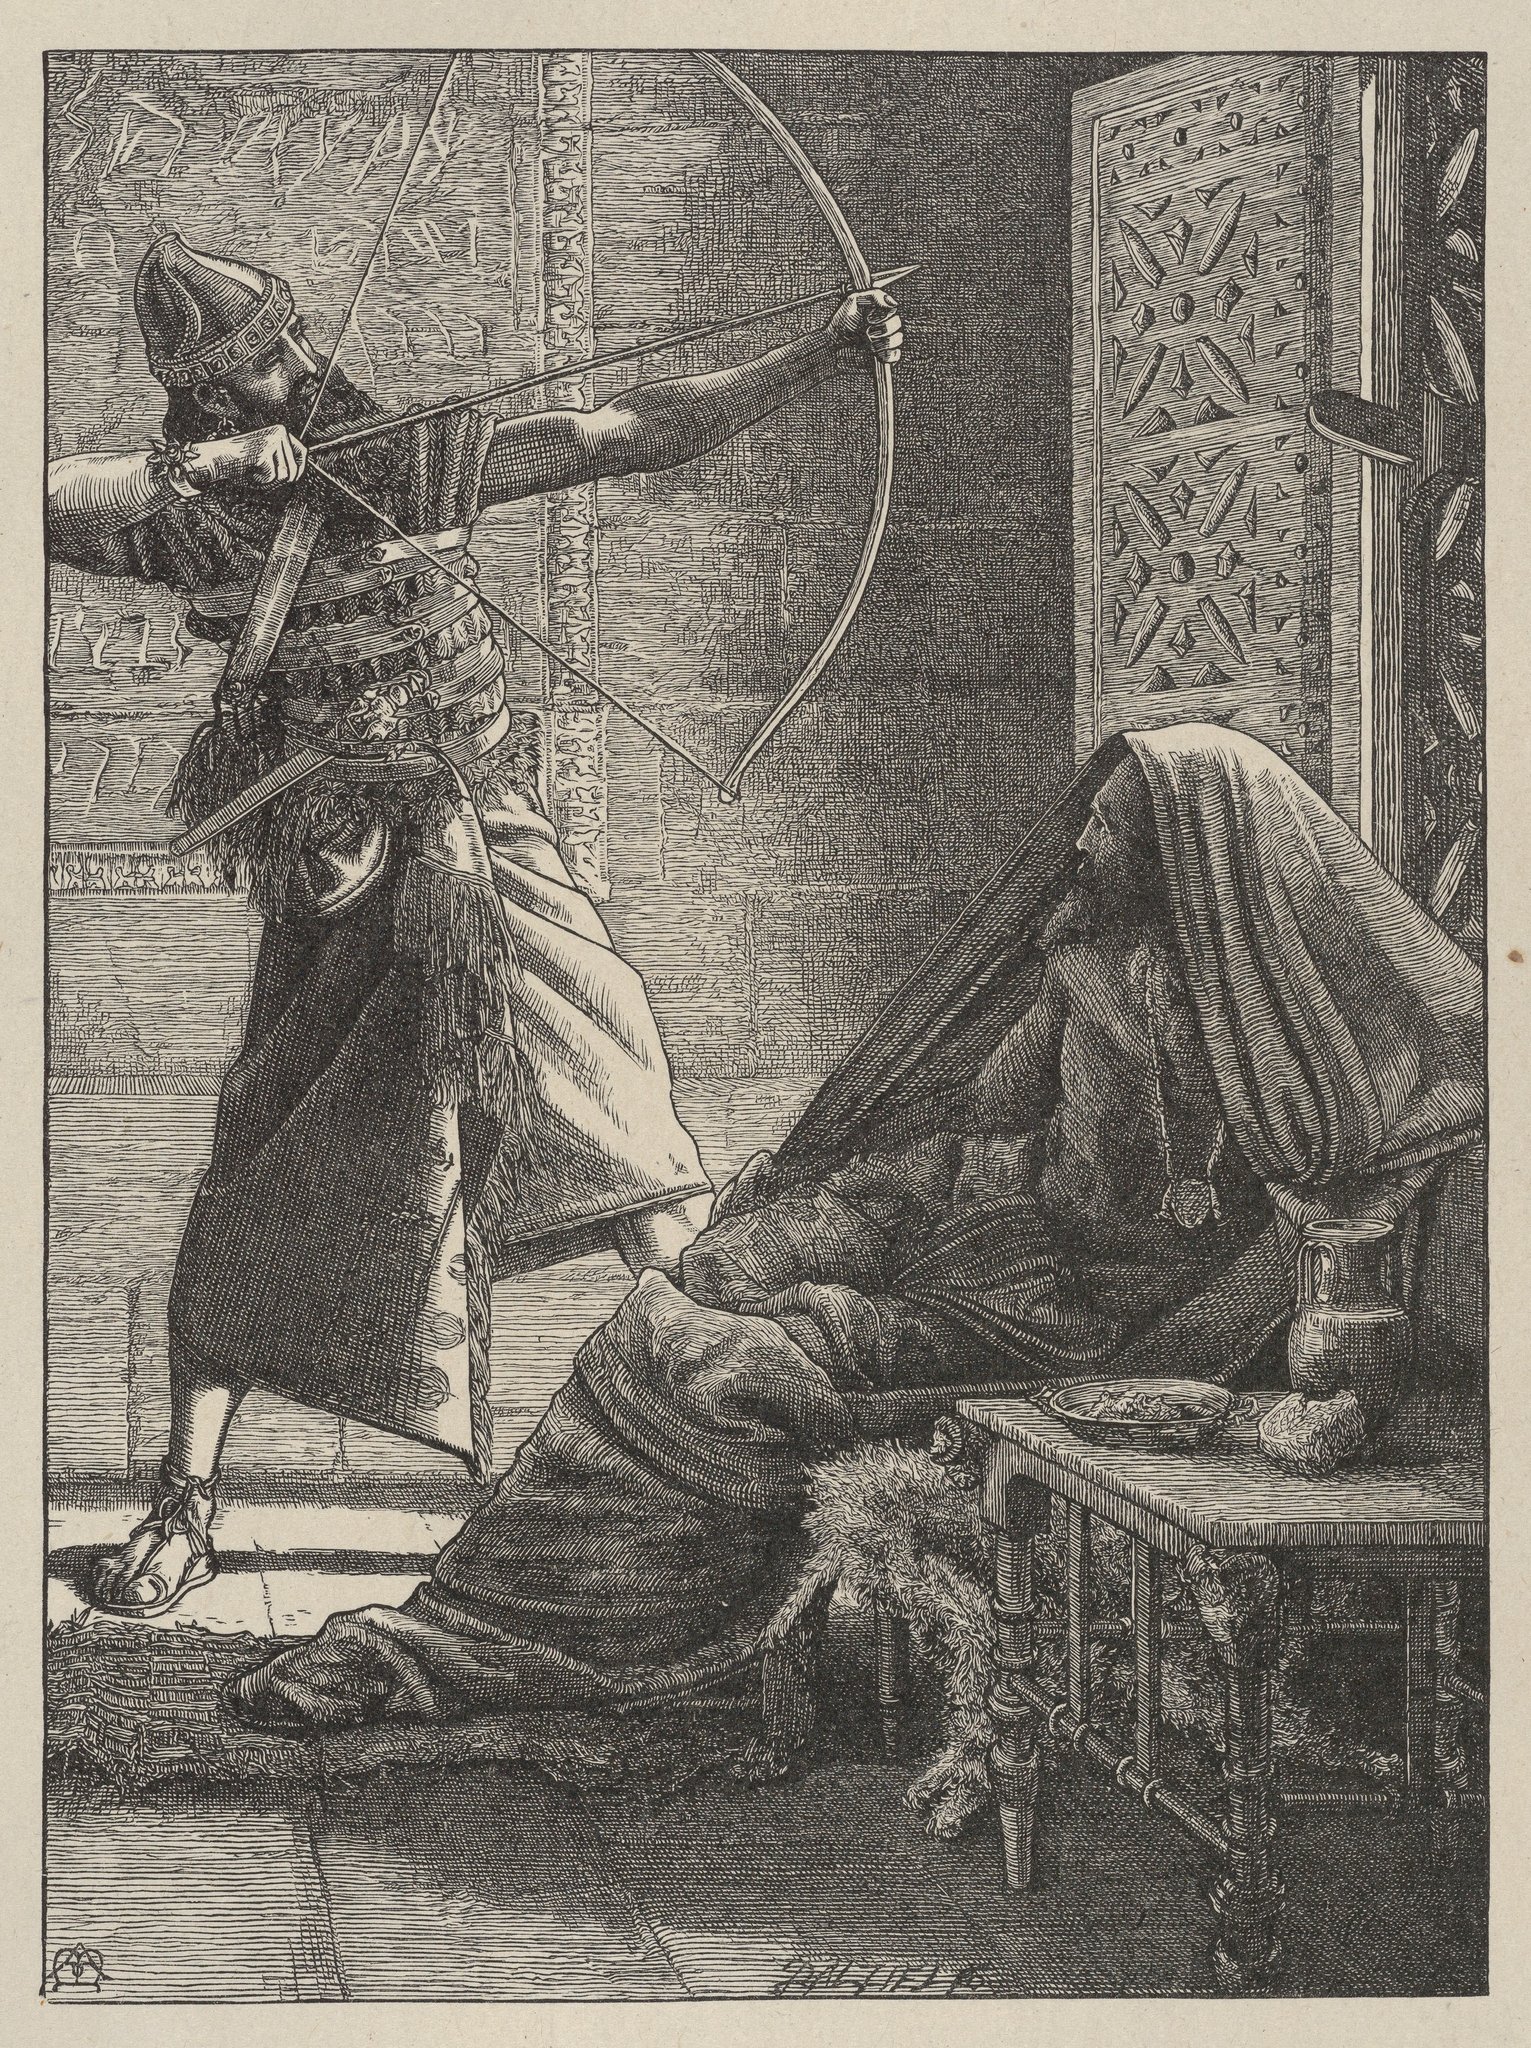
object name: print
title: The Arrow of Deliverance, from "Dalziels' Bible Gallery"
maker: arthur murch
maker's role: artist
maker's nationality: british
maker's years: 1836-1885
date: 1865-1881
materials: paper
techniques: engraving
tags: bow and arrow,men